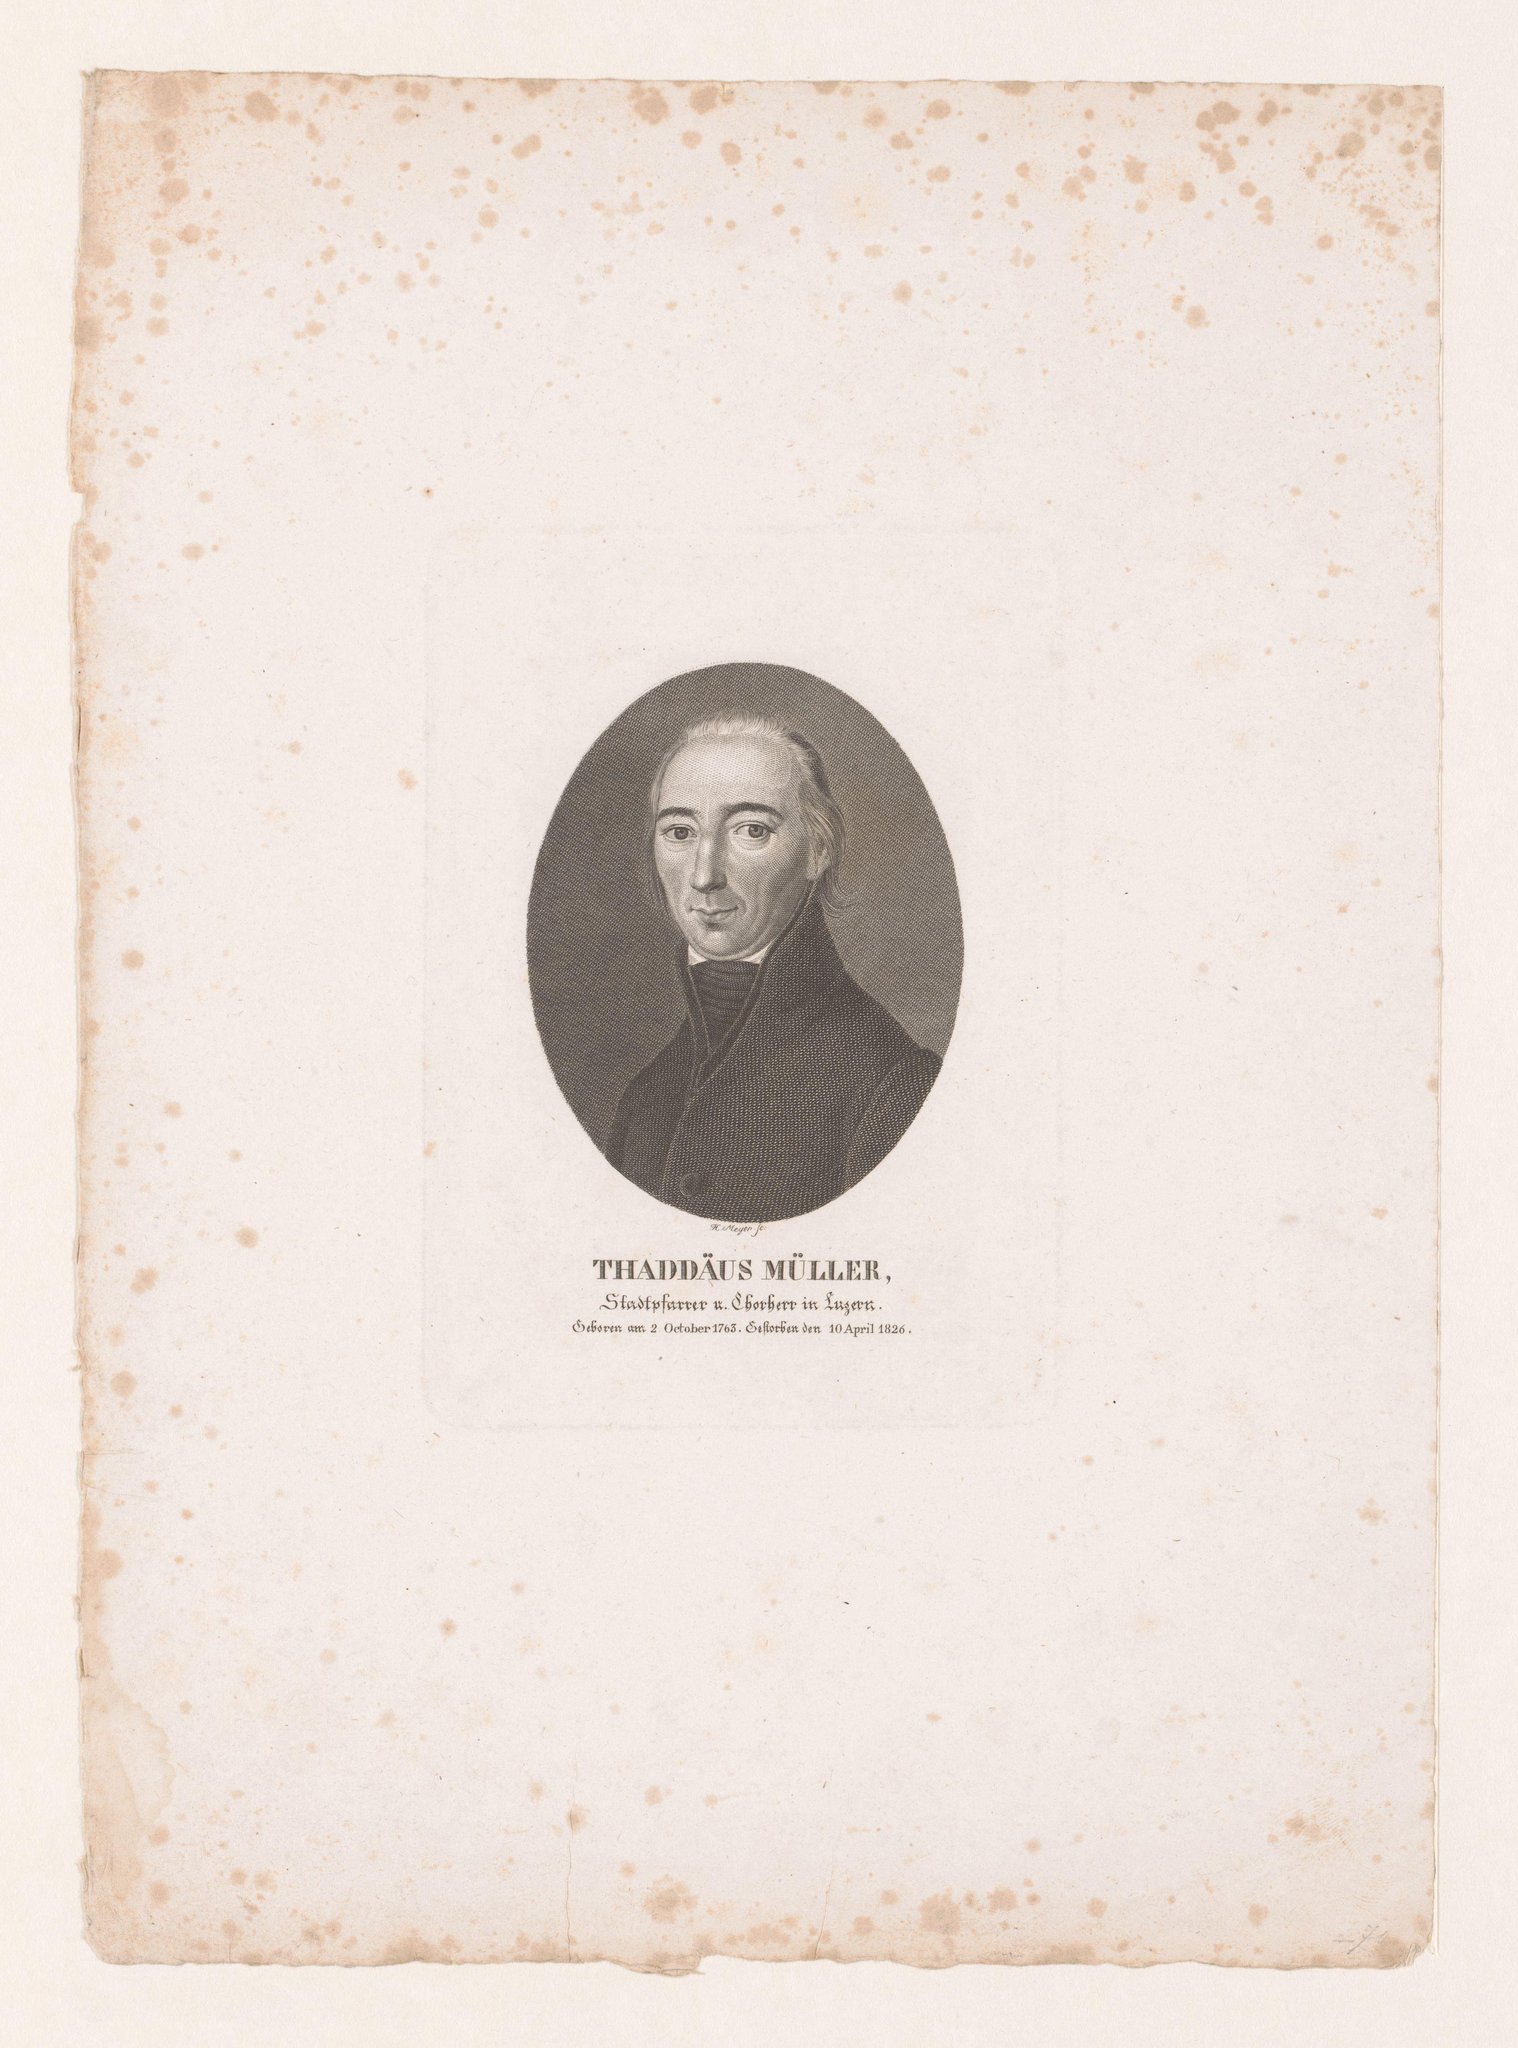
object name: print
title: Portret van Thaddäus Müller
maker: heinrich meyer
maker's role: print maker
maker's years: 1802-1877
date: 1826-1877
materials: paper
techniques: engraving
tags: historical persons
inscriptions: collector's mark: Lugt 2228